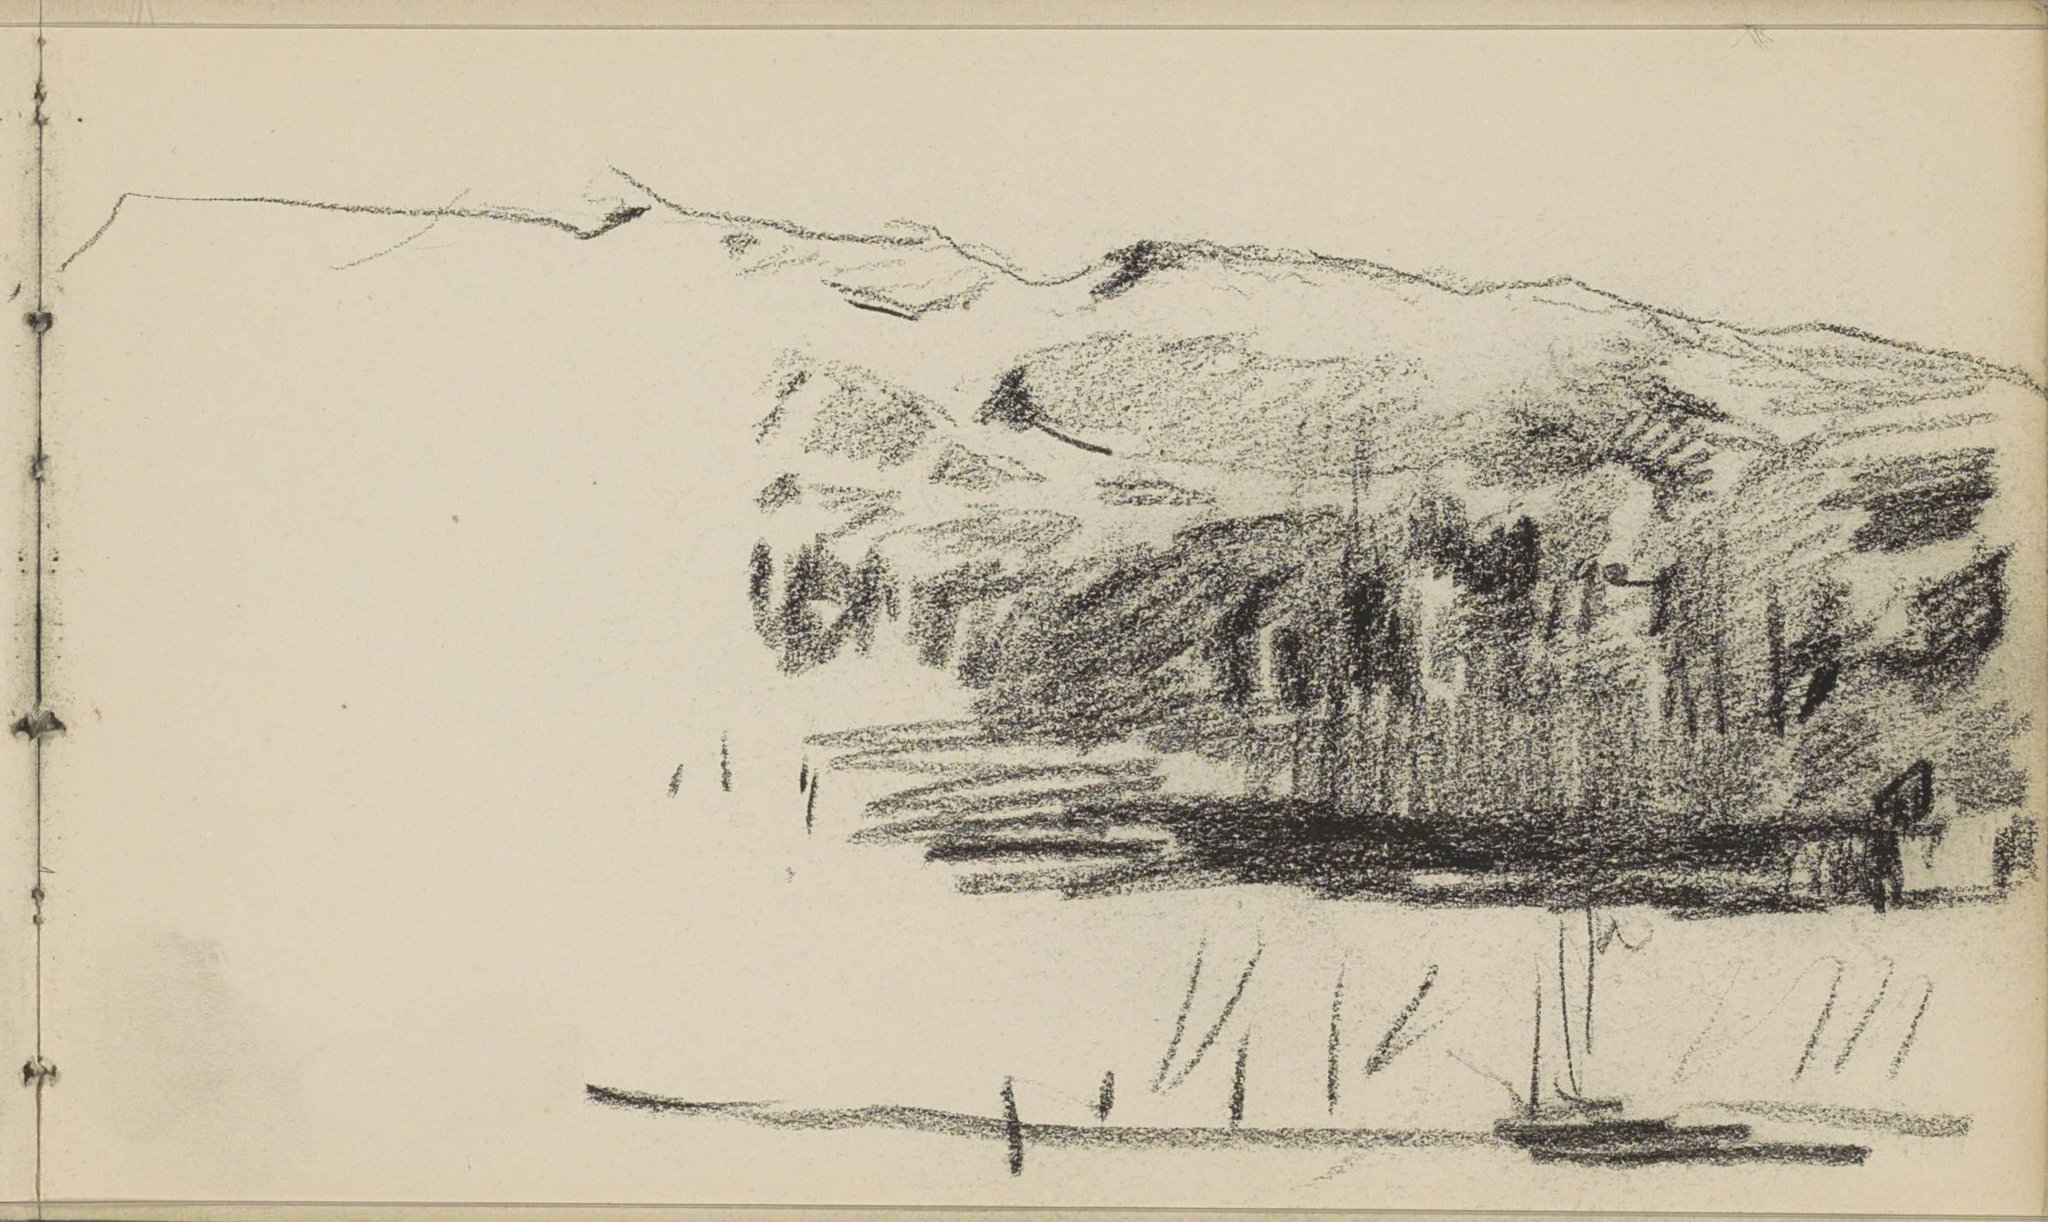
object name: sketchbook leaf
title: Berglandschap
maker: johan antonie de jonge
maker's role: draughtsman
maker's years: 1864-1927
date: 1901-1927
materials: chalk, paper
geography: germany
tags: mountains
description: Berglandschap. Vooraan mogelijk water. Blad 3 uit een schetsboek met 45 bladen.